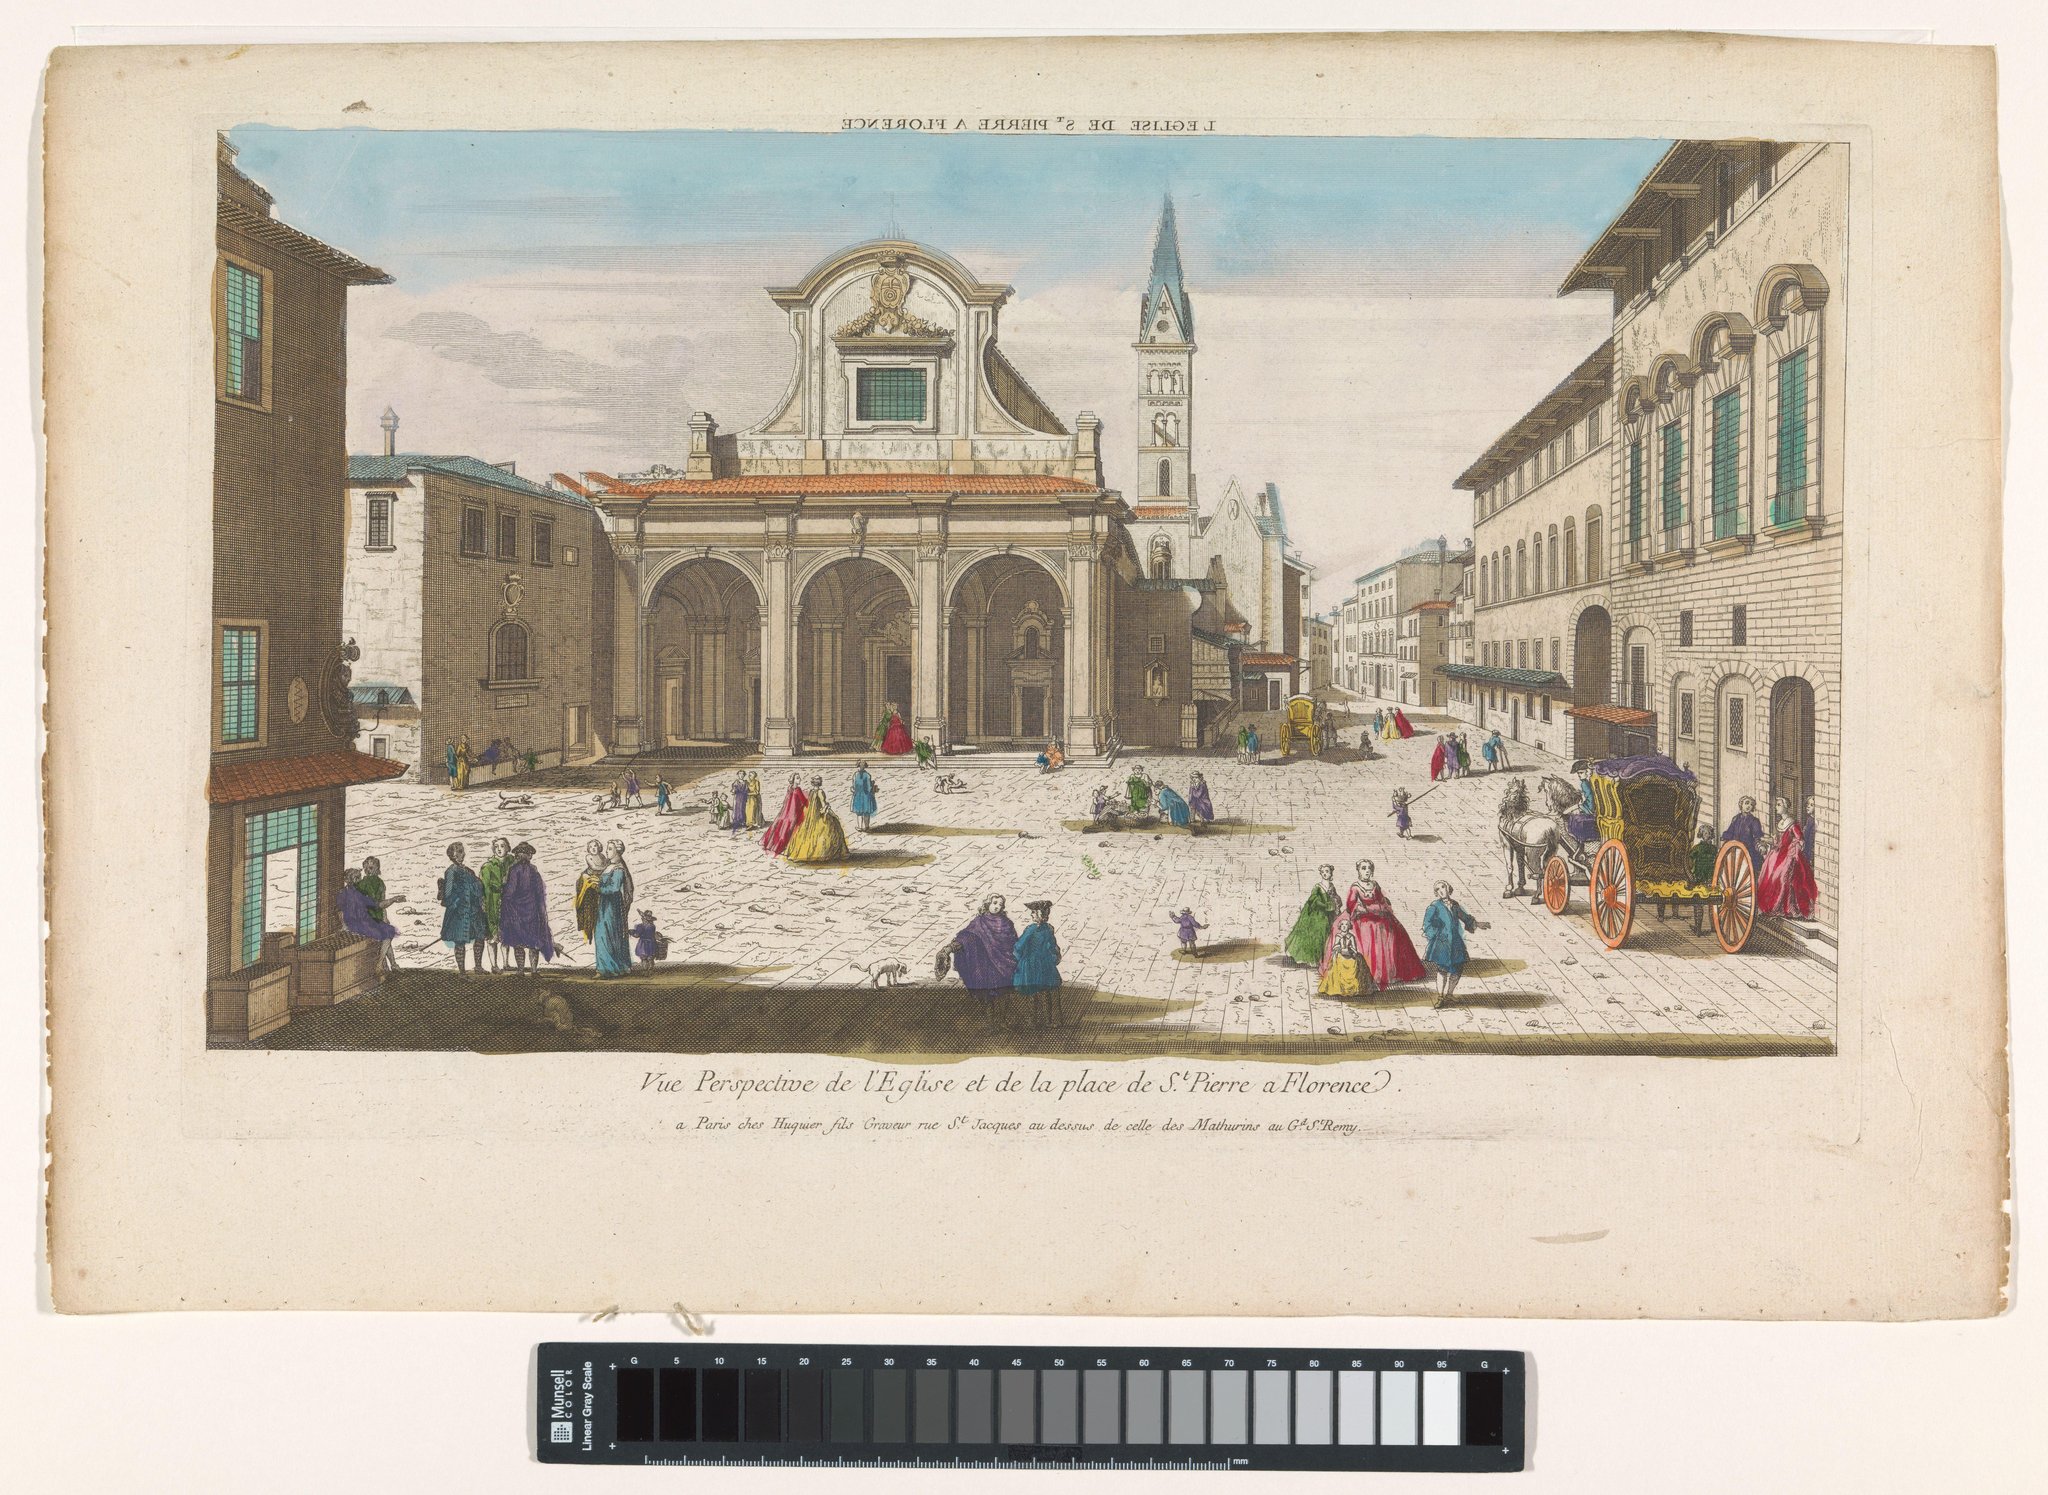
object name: print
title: Gezicht op de kerk en het plein San Pier Maggiore te Florence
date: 1735-1805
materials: paper, watercolor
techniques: brush, etching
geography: france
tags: church (exterior), square, place, circus, etc. (+ city(-scape) with figures, staffage)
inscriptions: collector's mark: Lugt 2166, watermark